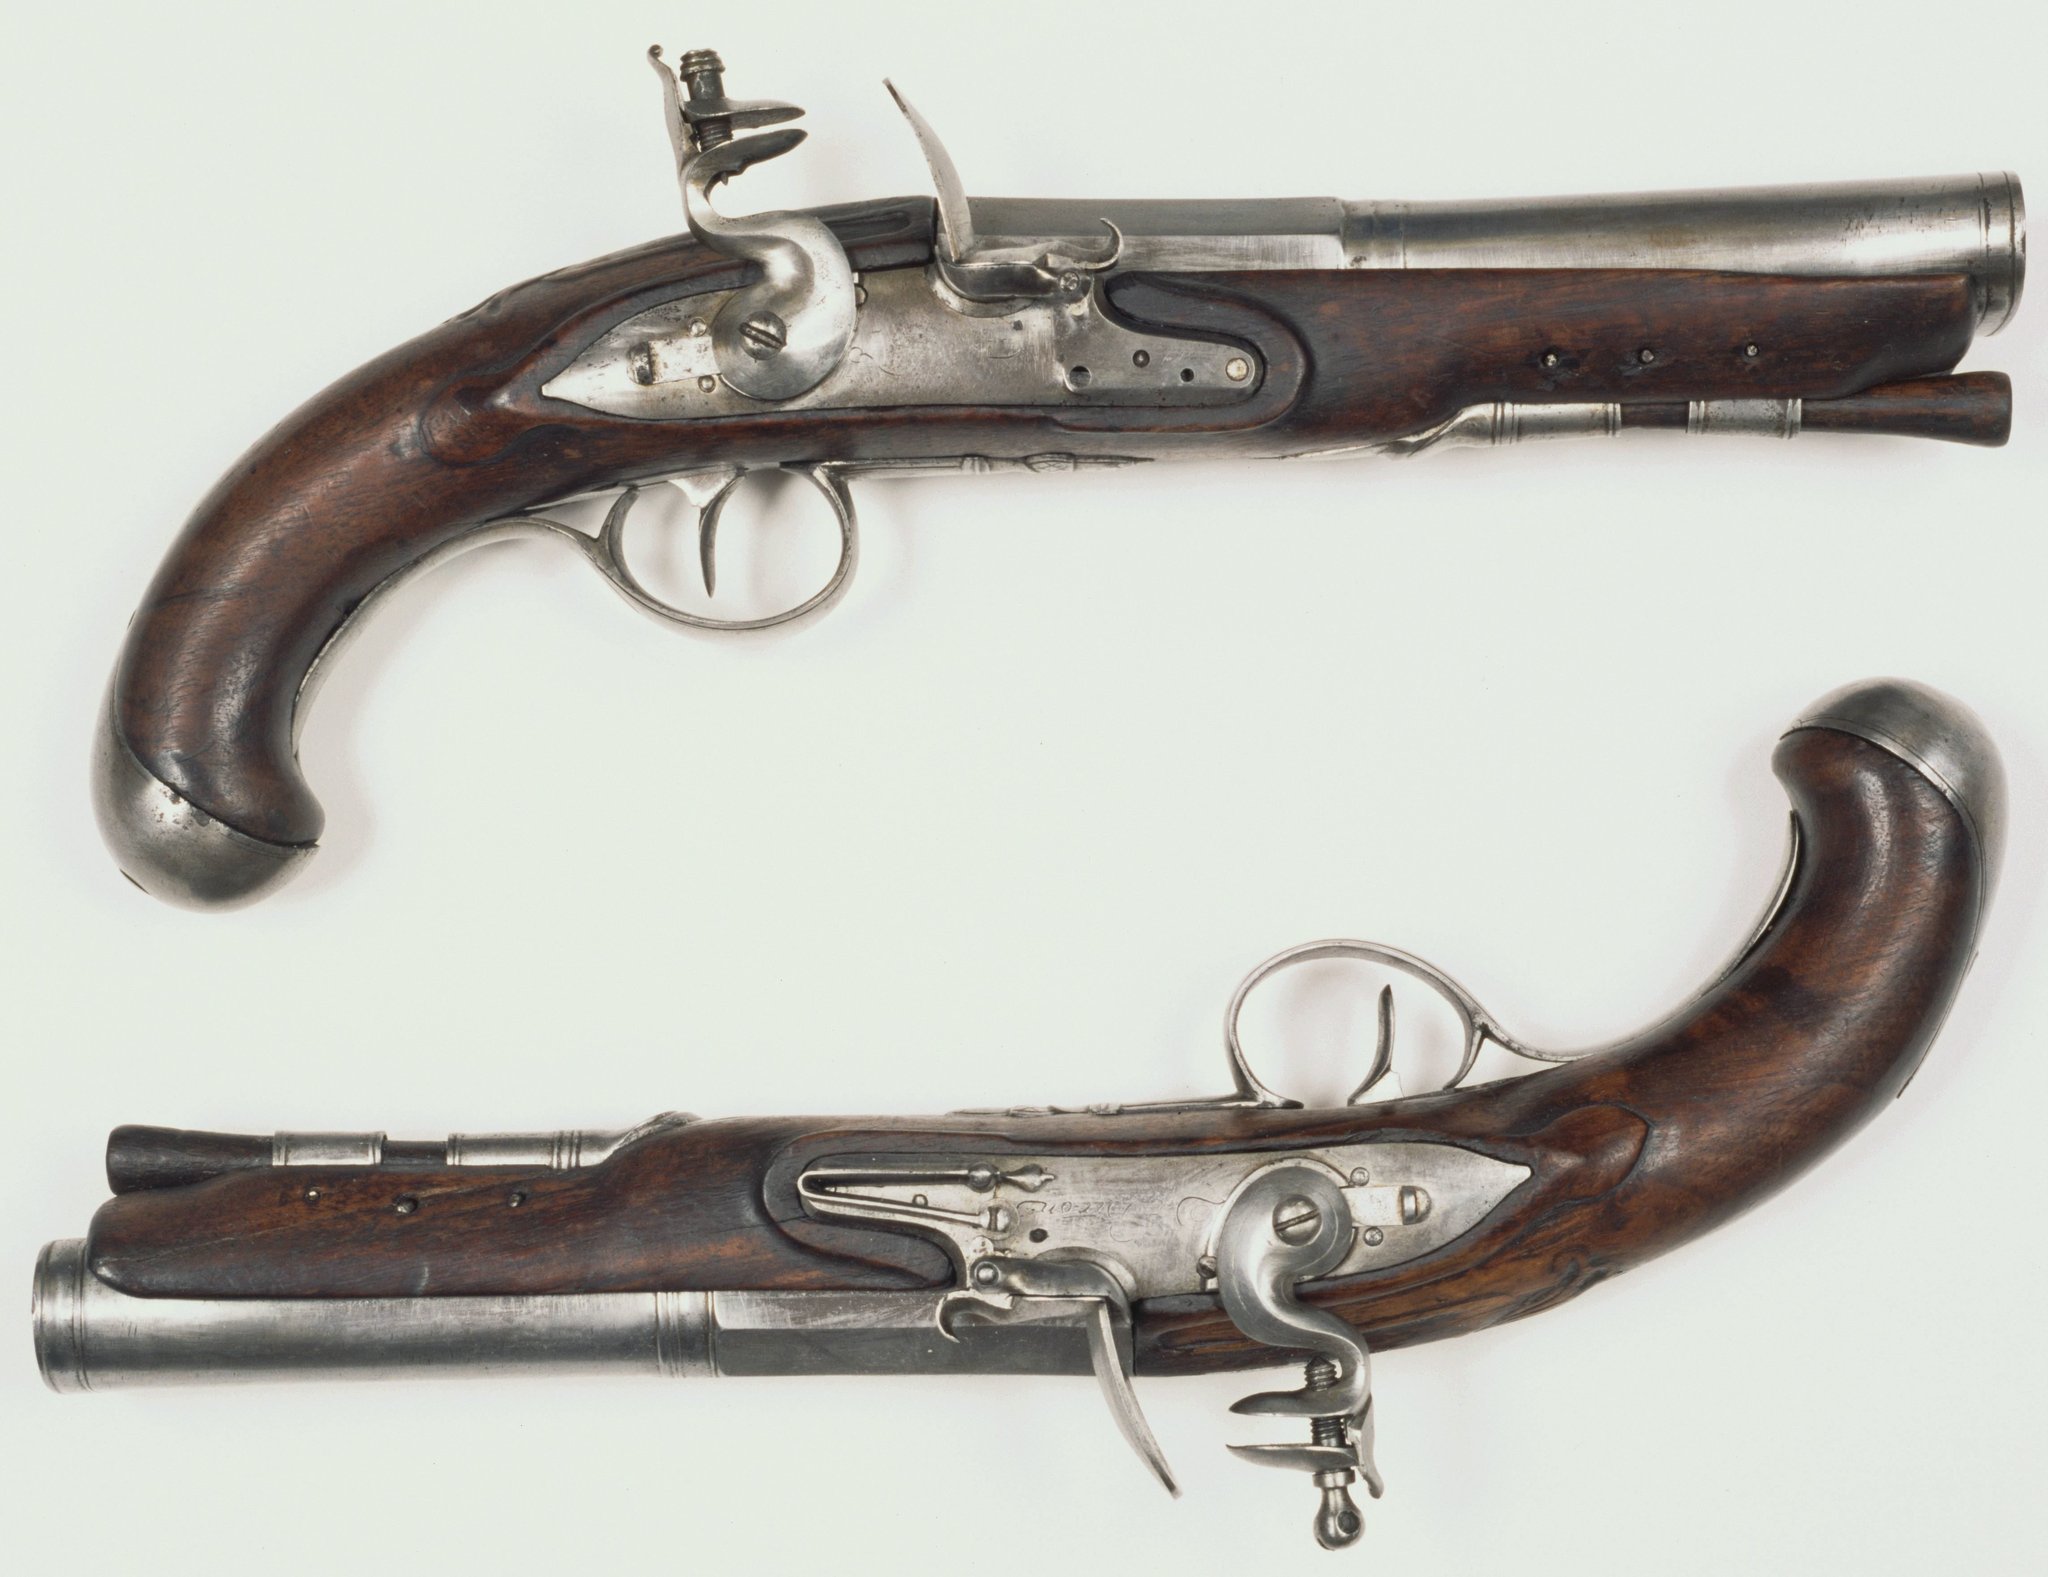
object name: flintlock pistol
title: Vuursteenpistool met afgeplat tromblon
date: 1782-1810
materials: iron, wood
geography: liège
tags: noordzeekanaal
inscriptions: mark: ‘Dit Biron’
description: Vuursteenpistool met afgeplat tromblon, ronde loop die wordt onderbroken door een profielband waarna de loop achthoekig eindigt. Houten lade met drie ijzeren pinnen. De slotkast is geheel van ijzer, vuurstaal is los bevestigd. De kolf is van hout en heeft een ijzeren kolfkap. De trekkerbeugel geheel van ijzer en heeft aan het uiteinde de vorm van een eikeltje. Onder de lade een houten laadstok in een ijzeren laadstokkoker